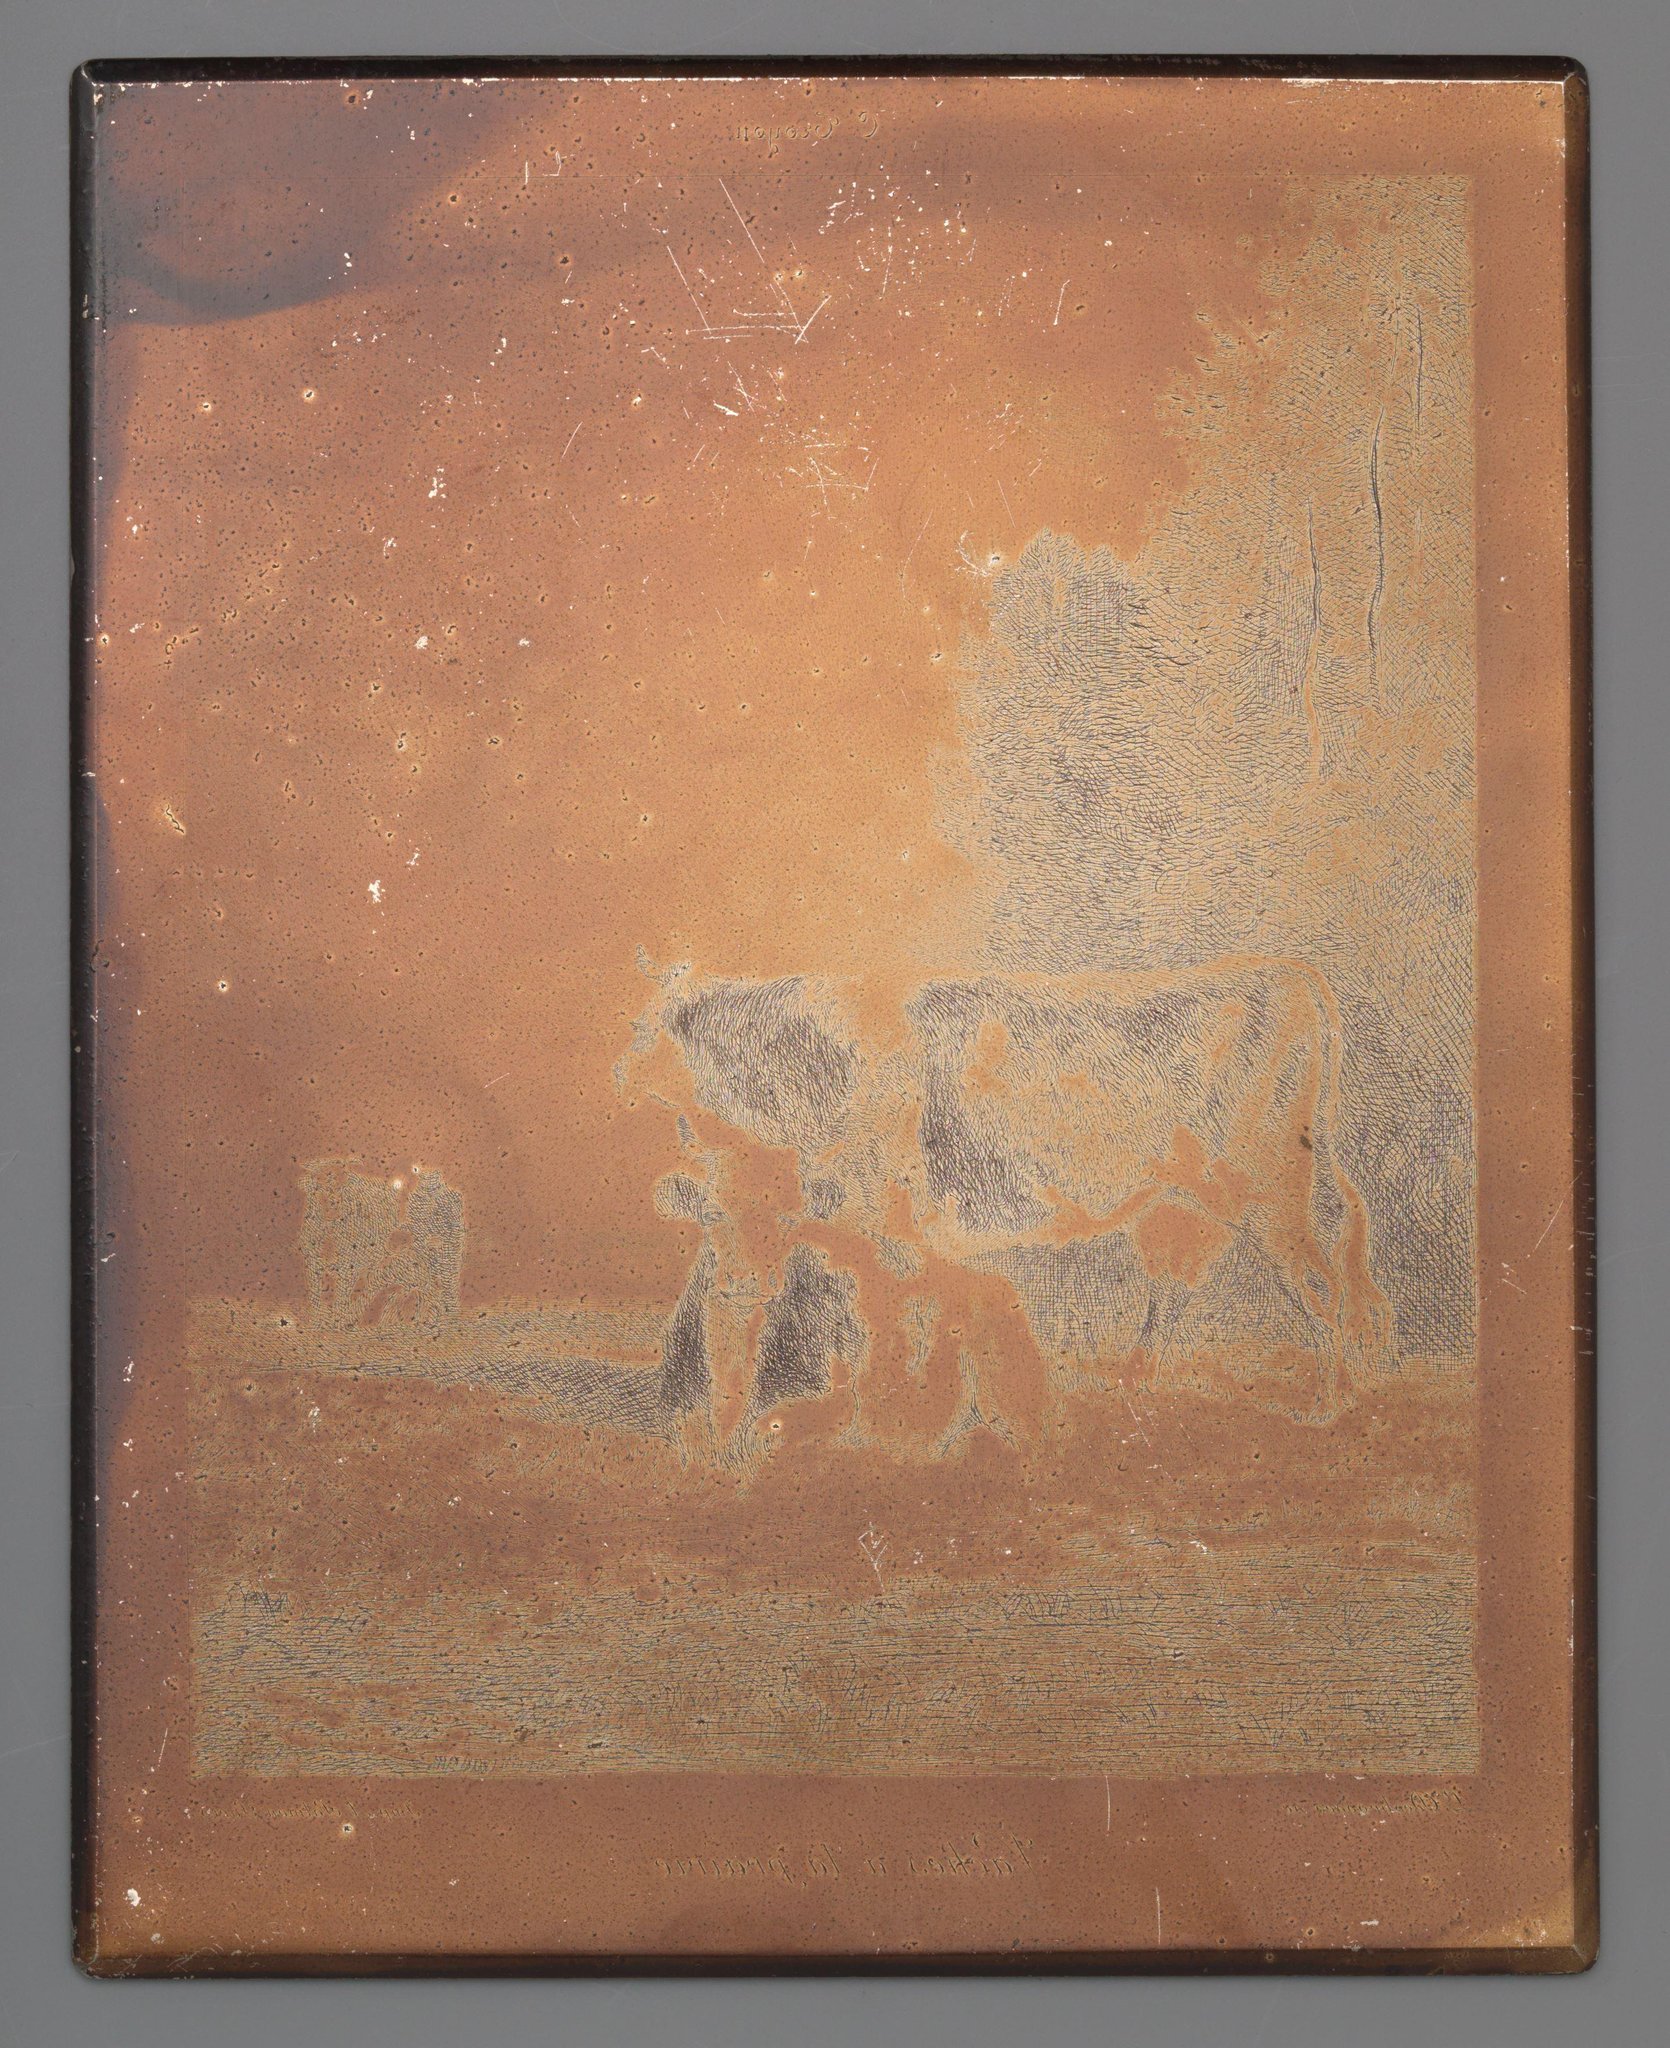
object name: staalplaat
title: Vaches à la prairie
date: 1863-1880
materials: steel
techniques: etching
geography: paris